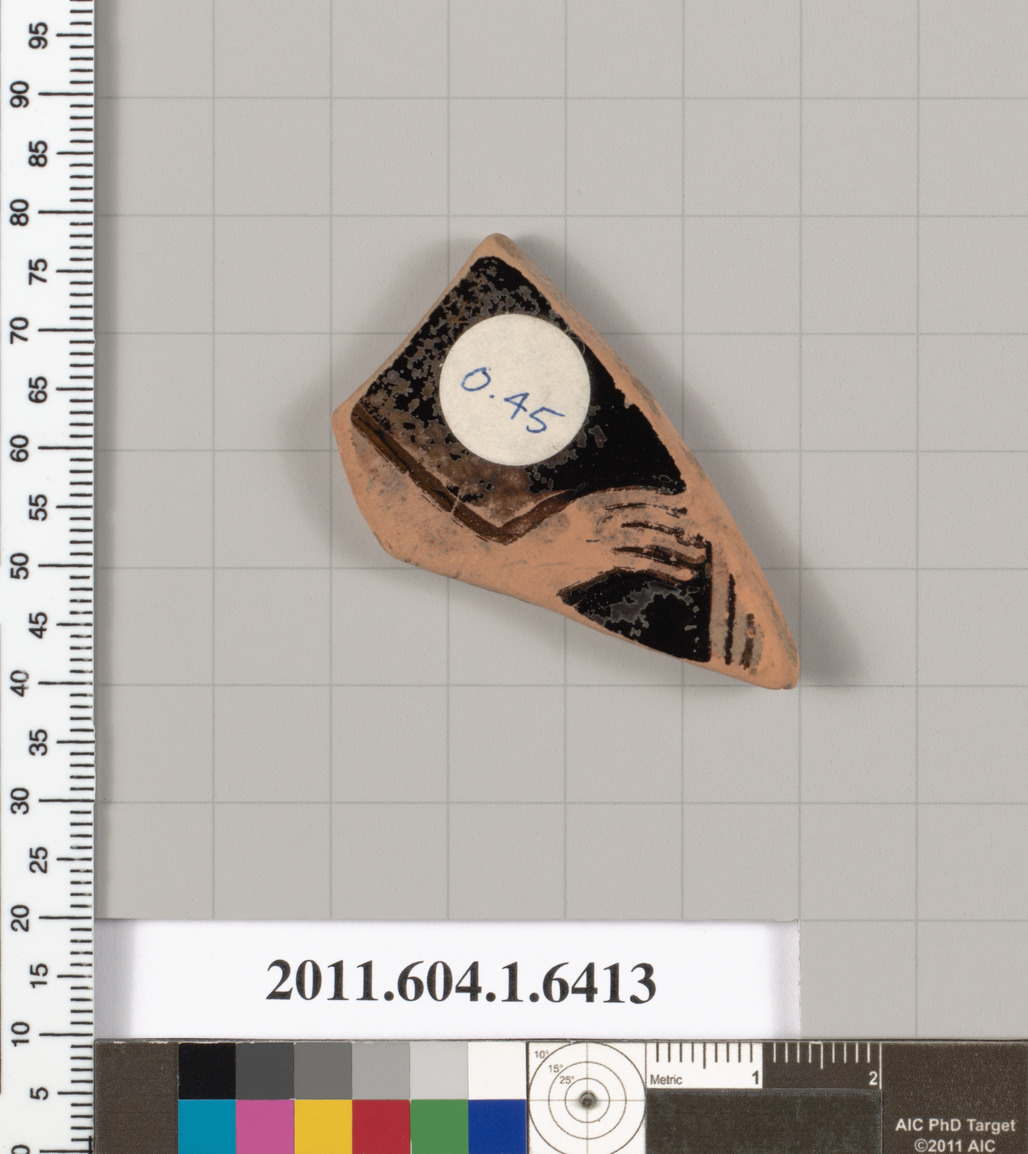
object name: kylix fragment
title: Terracotta fragment of a kylix (drinking cup)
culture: greek, attic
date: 490-480 BCE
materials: terracotta